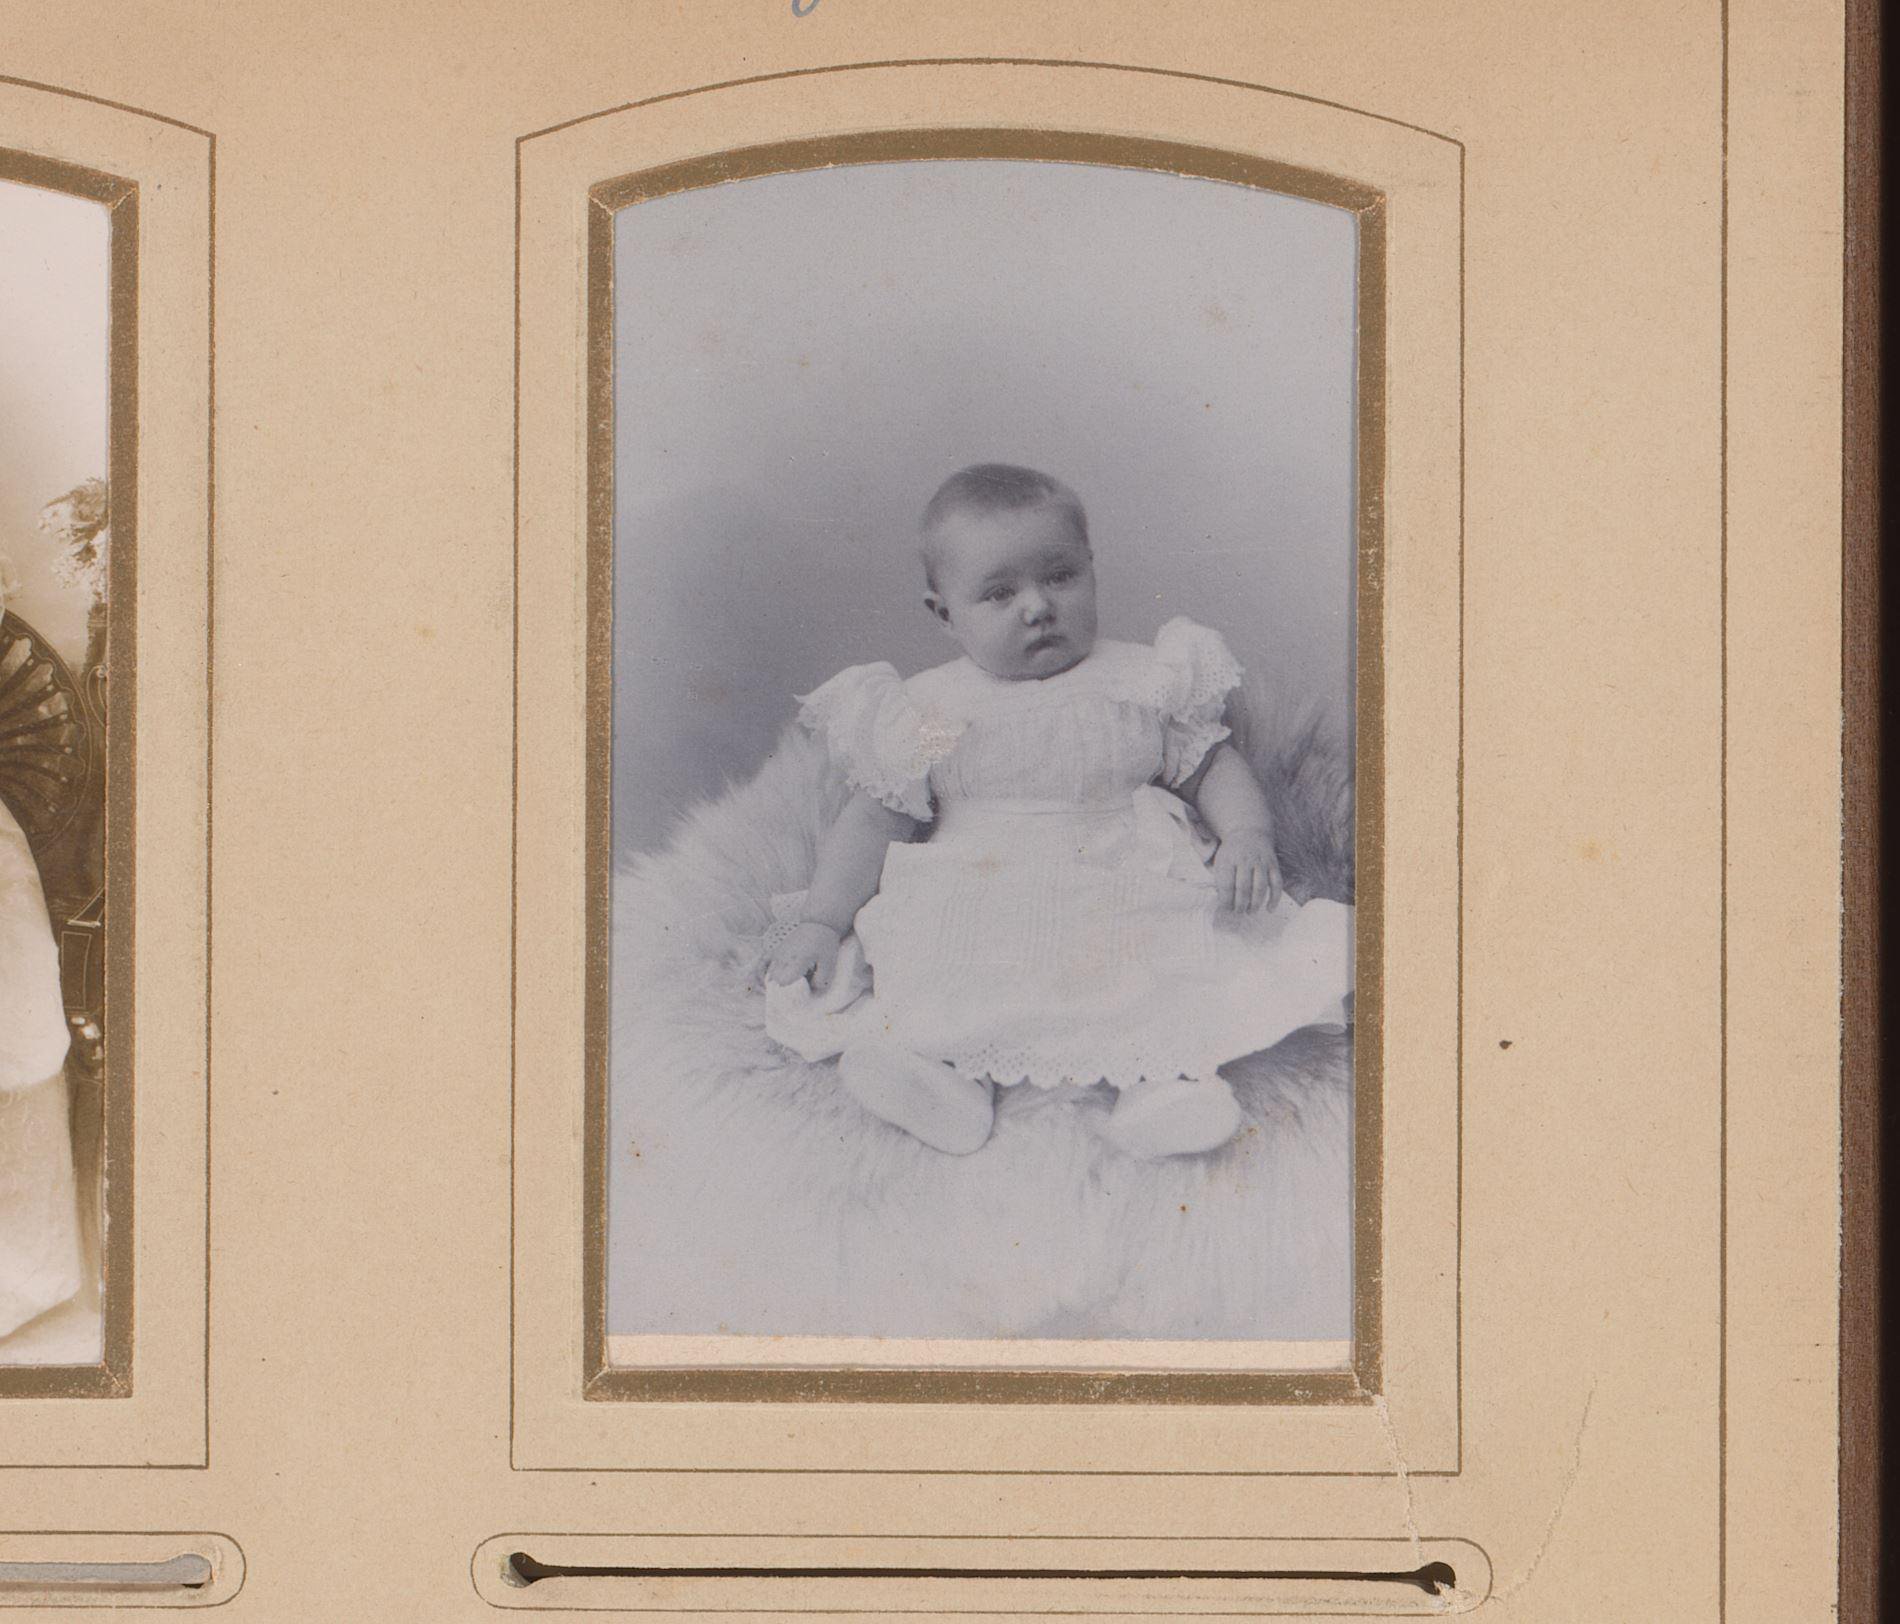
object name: photograph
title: Portret van Cootje Roos als baby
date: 1888-1896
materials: cardboard, photographic support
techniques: collodion silver print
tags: historical persons - bb - woman, infant, baby ~ the ages of man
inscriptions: annotation: ‘Cootje Roos.’, inscription: ‘C.J.L. Vermeulen/ Den Haag/ Toussaintkade 11/ Intercommunal Telephoon 774/ Amsterdam/ Heiligenweg hoek Singel./ Telephoon No 2340./ Utrecht/ Nieuwe gracht 50./ Telephoon No. 750.’